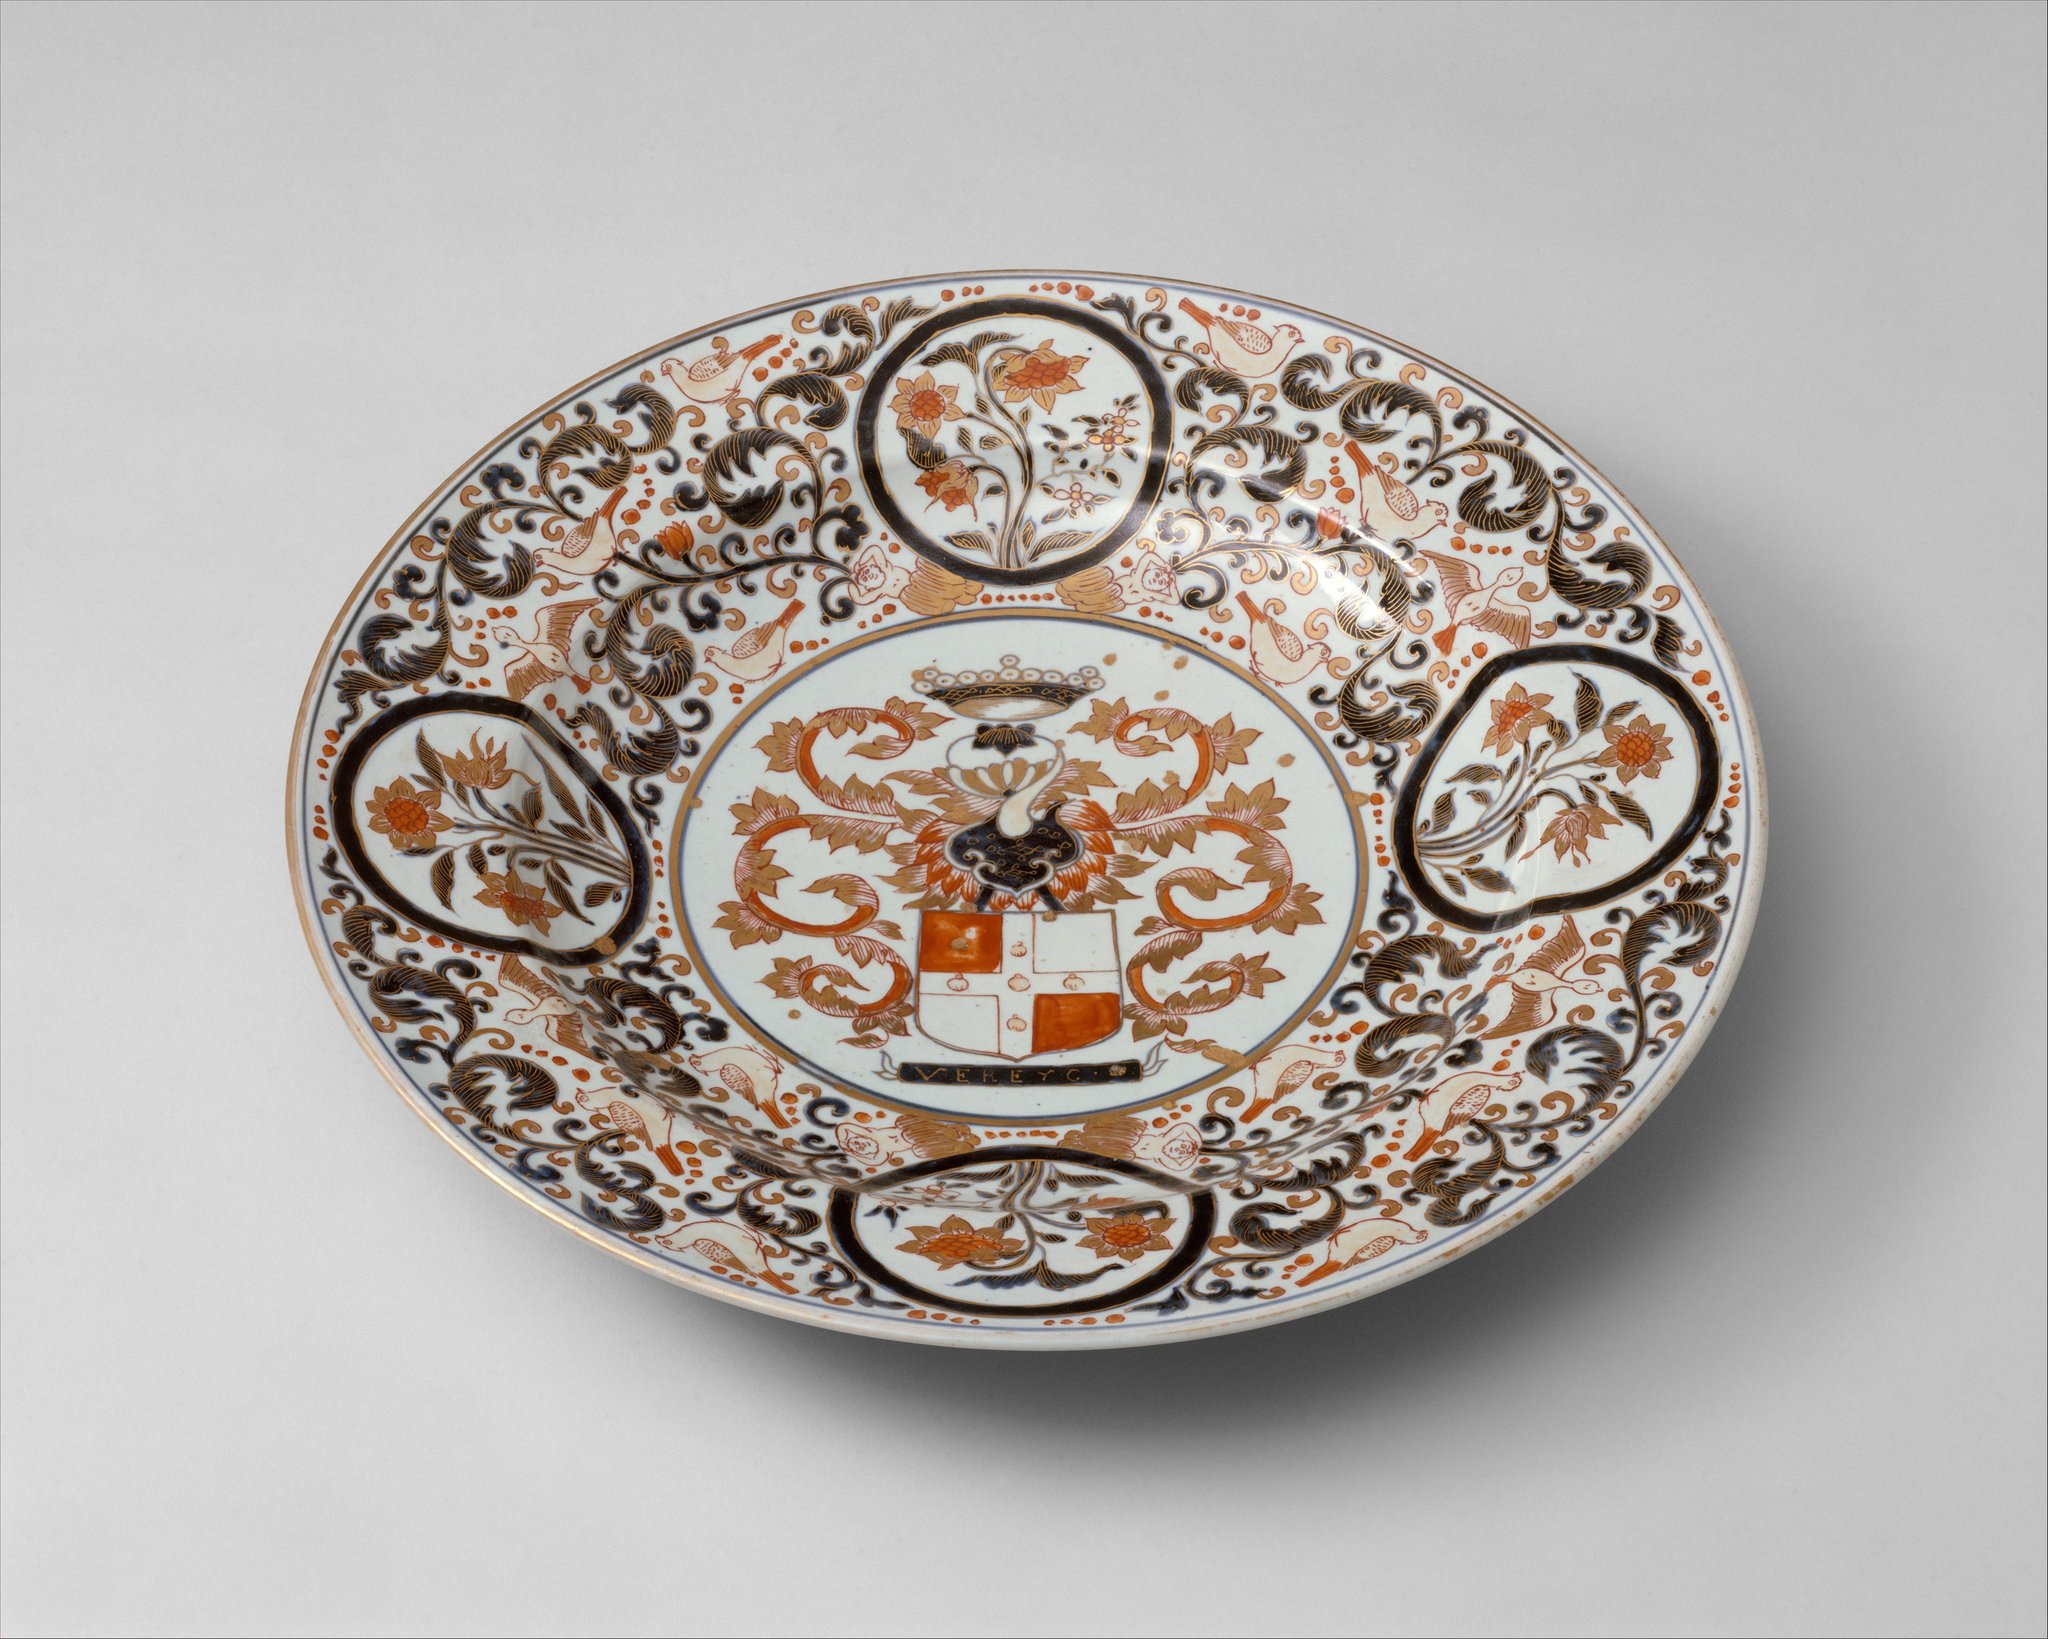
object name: plate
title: Armorial Plate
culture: japanese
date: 1690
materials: gold, porcelain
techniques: underglaze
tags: flowers,coat of arms